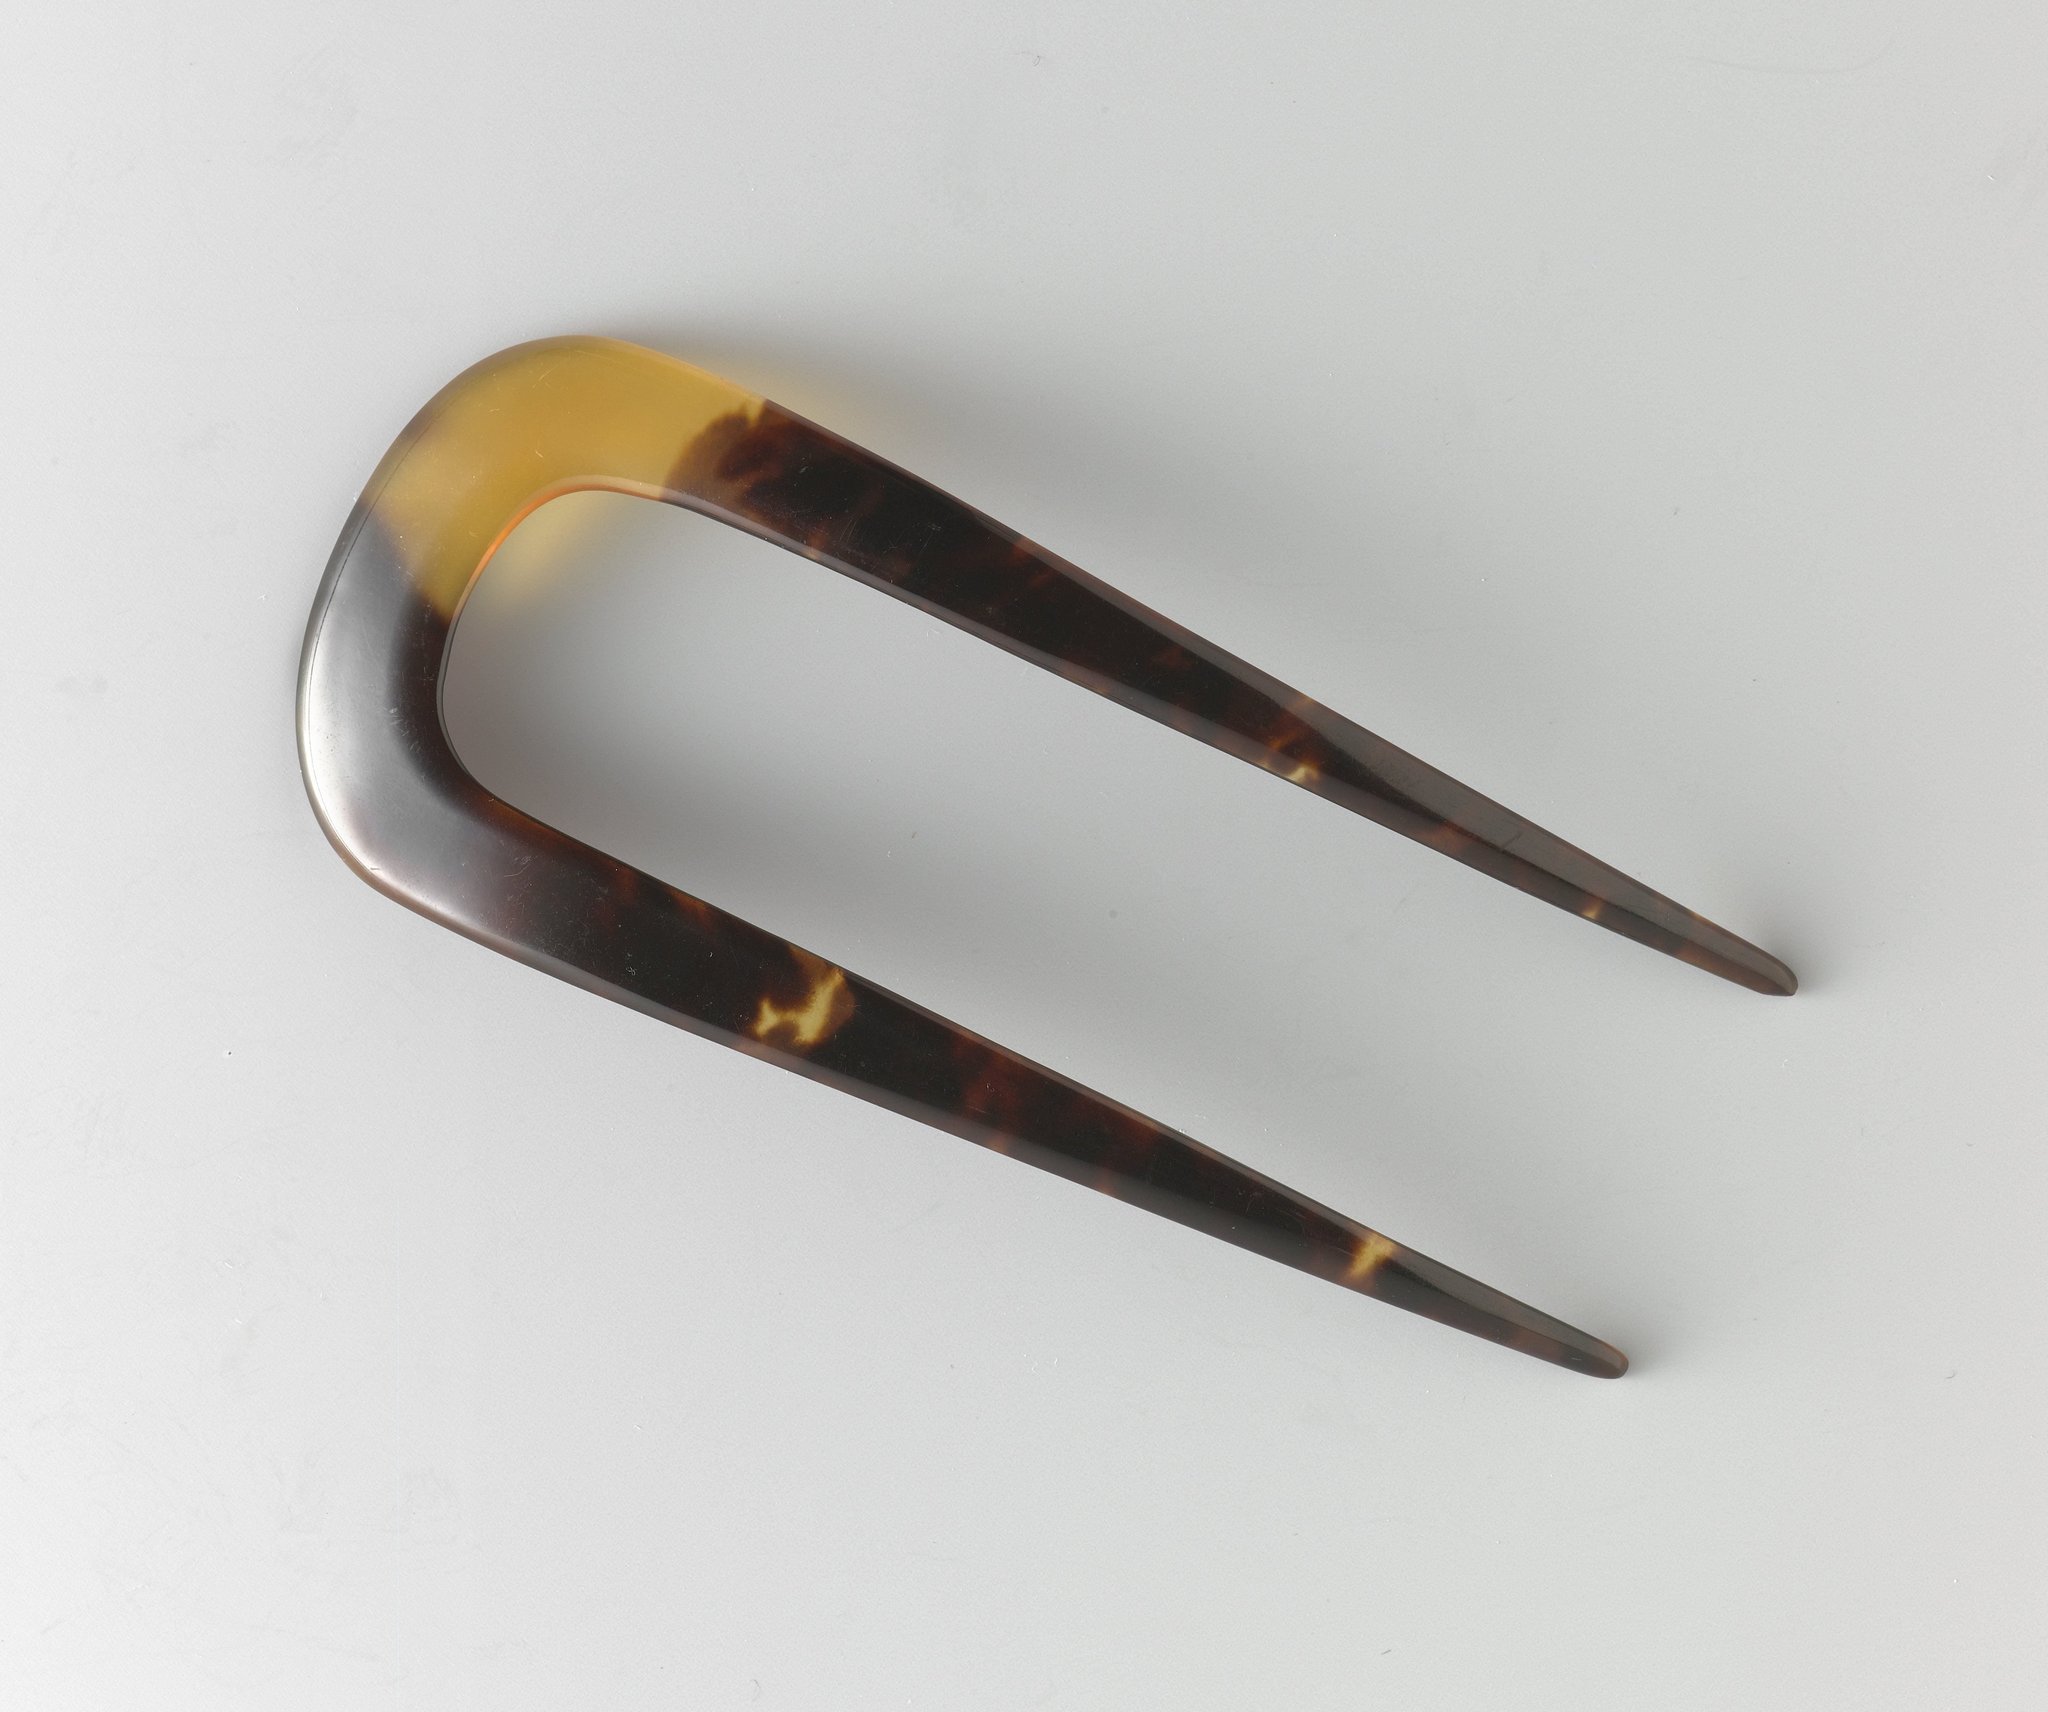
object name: comb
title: Haarkam van imitatie schildpad, U-vormig met gladde afgeronde rug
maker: Anonymous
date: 1885-1900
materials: celluloid, plastic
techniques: filing, polish, pressing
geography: netherlands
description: Een omgekeerde U-vormige haarnaald. De buitenboog is vierkant de binnenboog afgerond. Van donker schildpad.